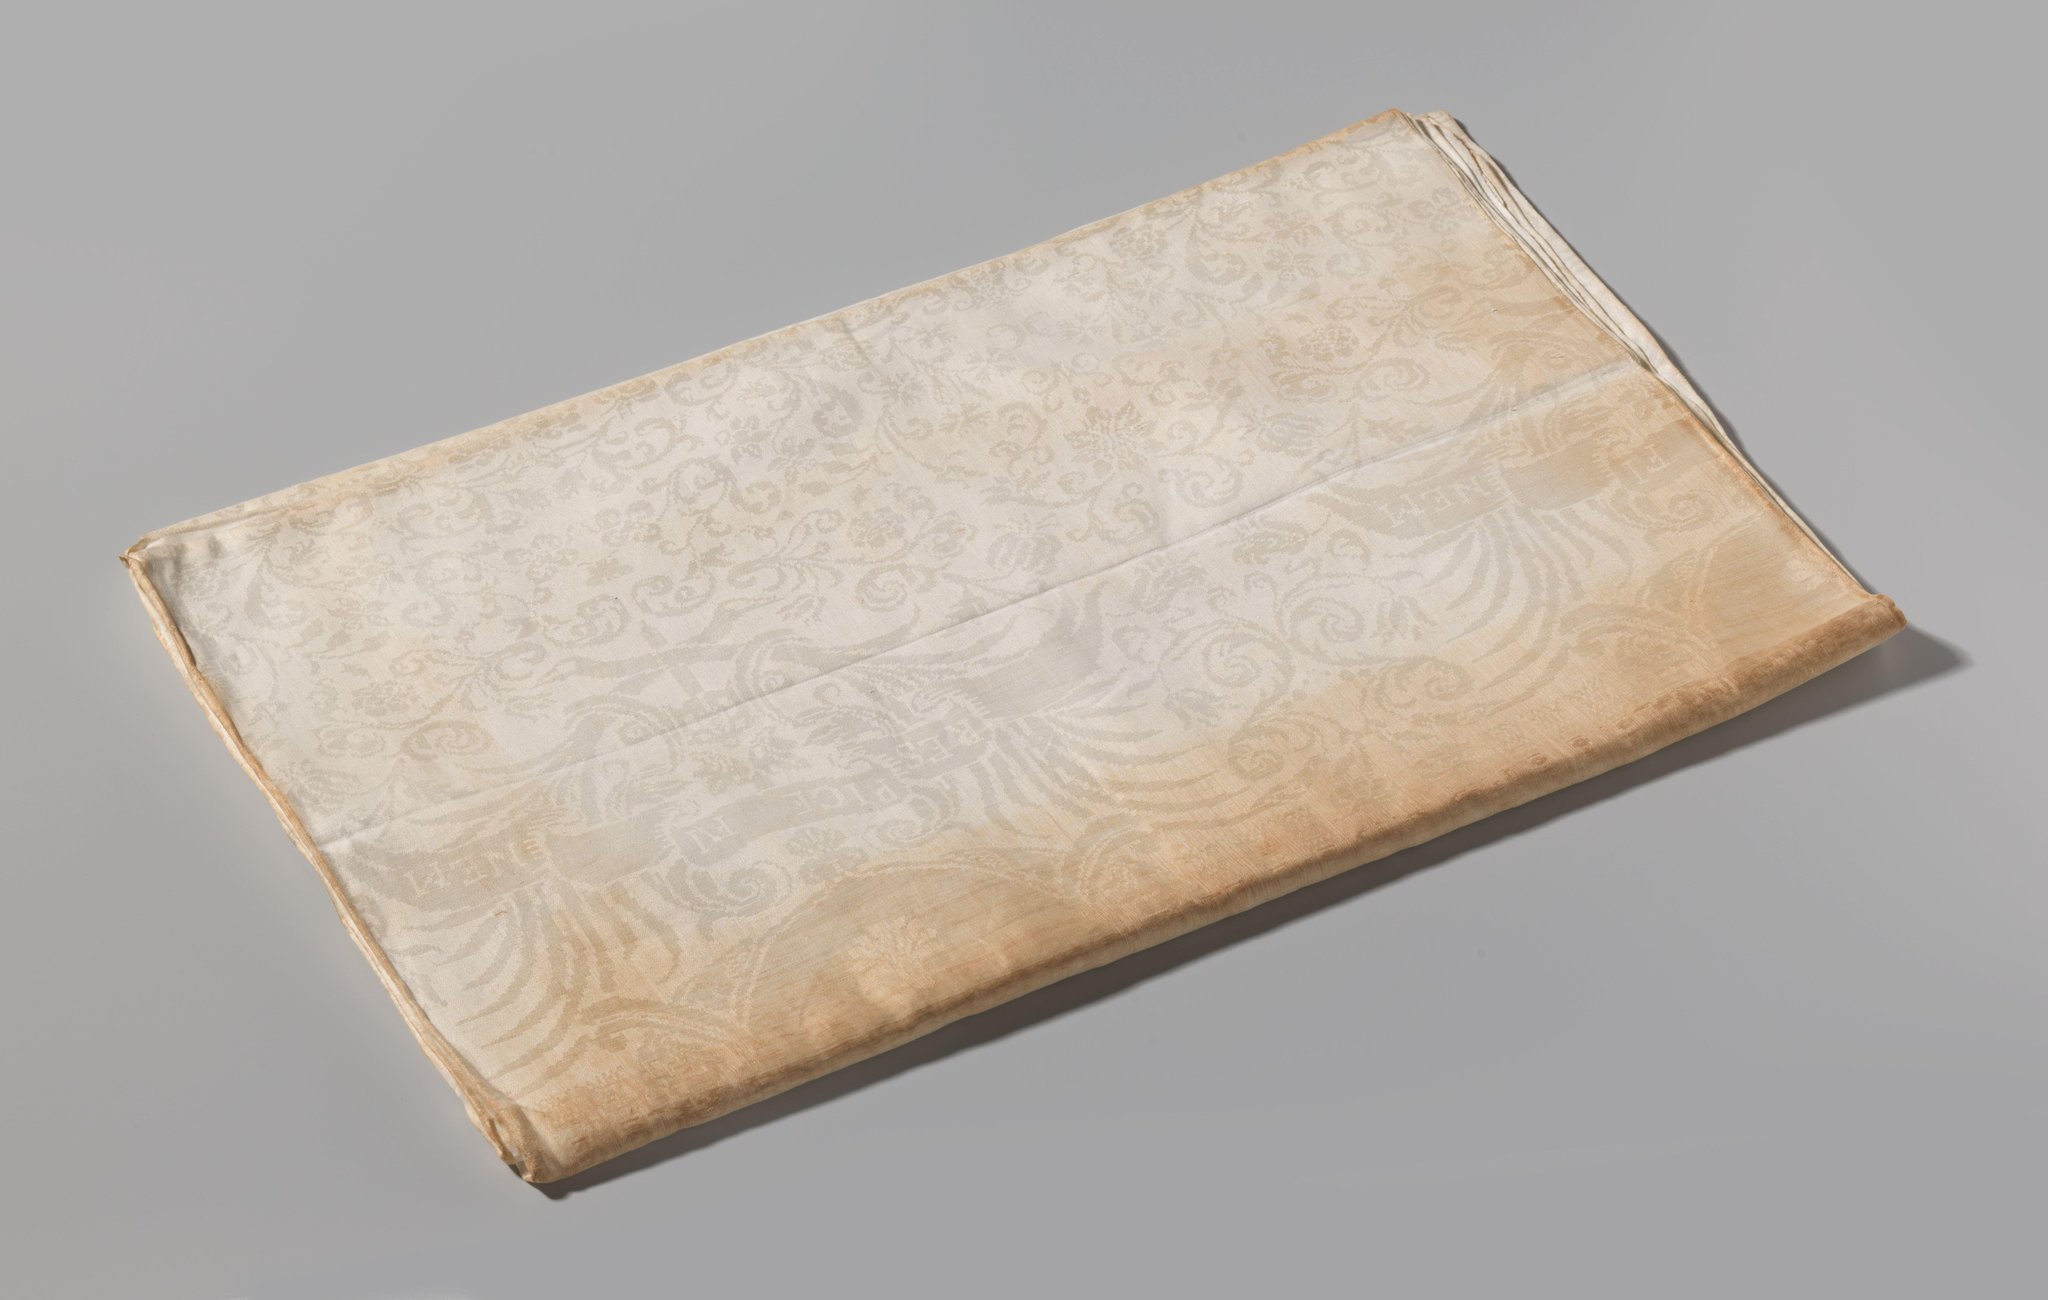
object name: tablecloth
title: Tafellaken van linnendamast met een wapen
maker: Anonymous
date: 1700-1710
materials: linen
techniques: damask, weave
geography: flanders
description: Tafellaken van linnendamast met het wapen van P.E. van der Noot. Bij het laken horen vier servetten (BK-1977-290-A t/m BK-1977-290-D).